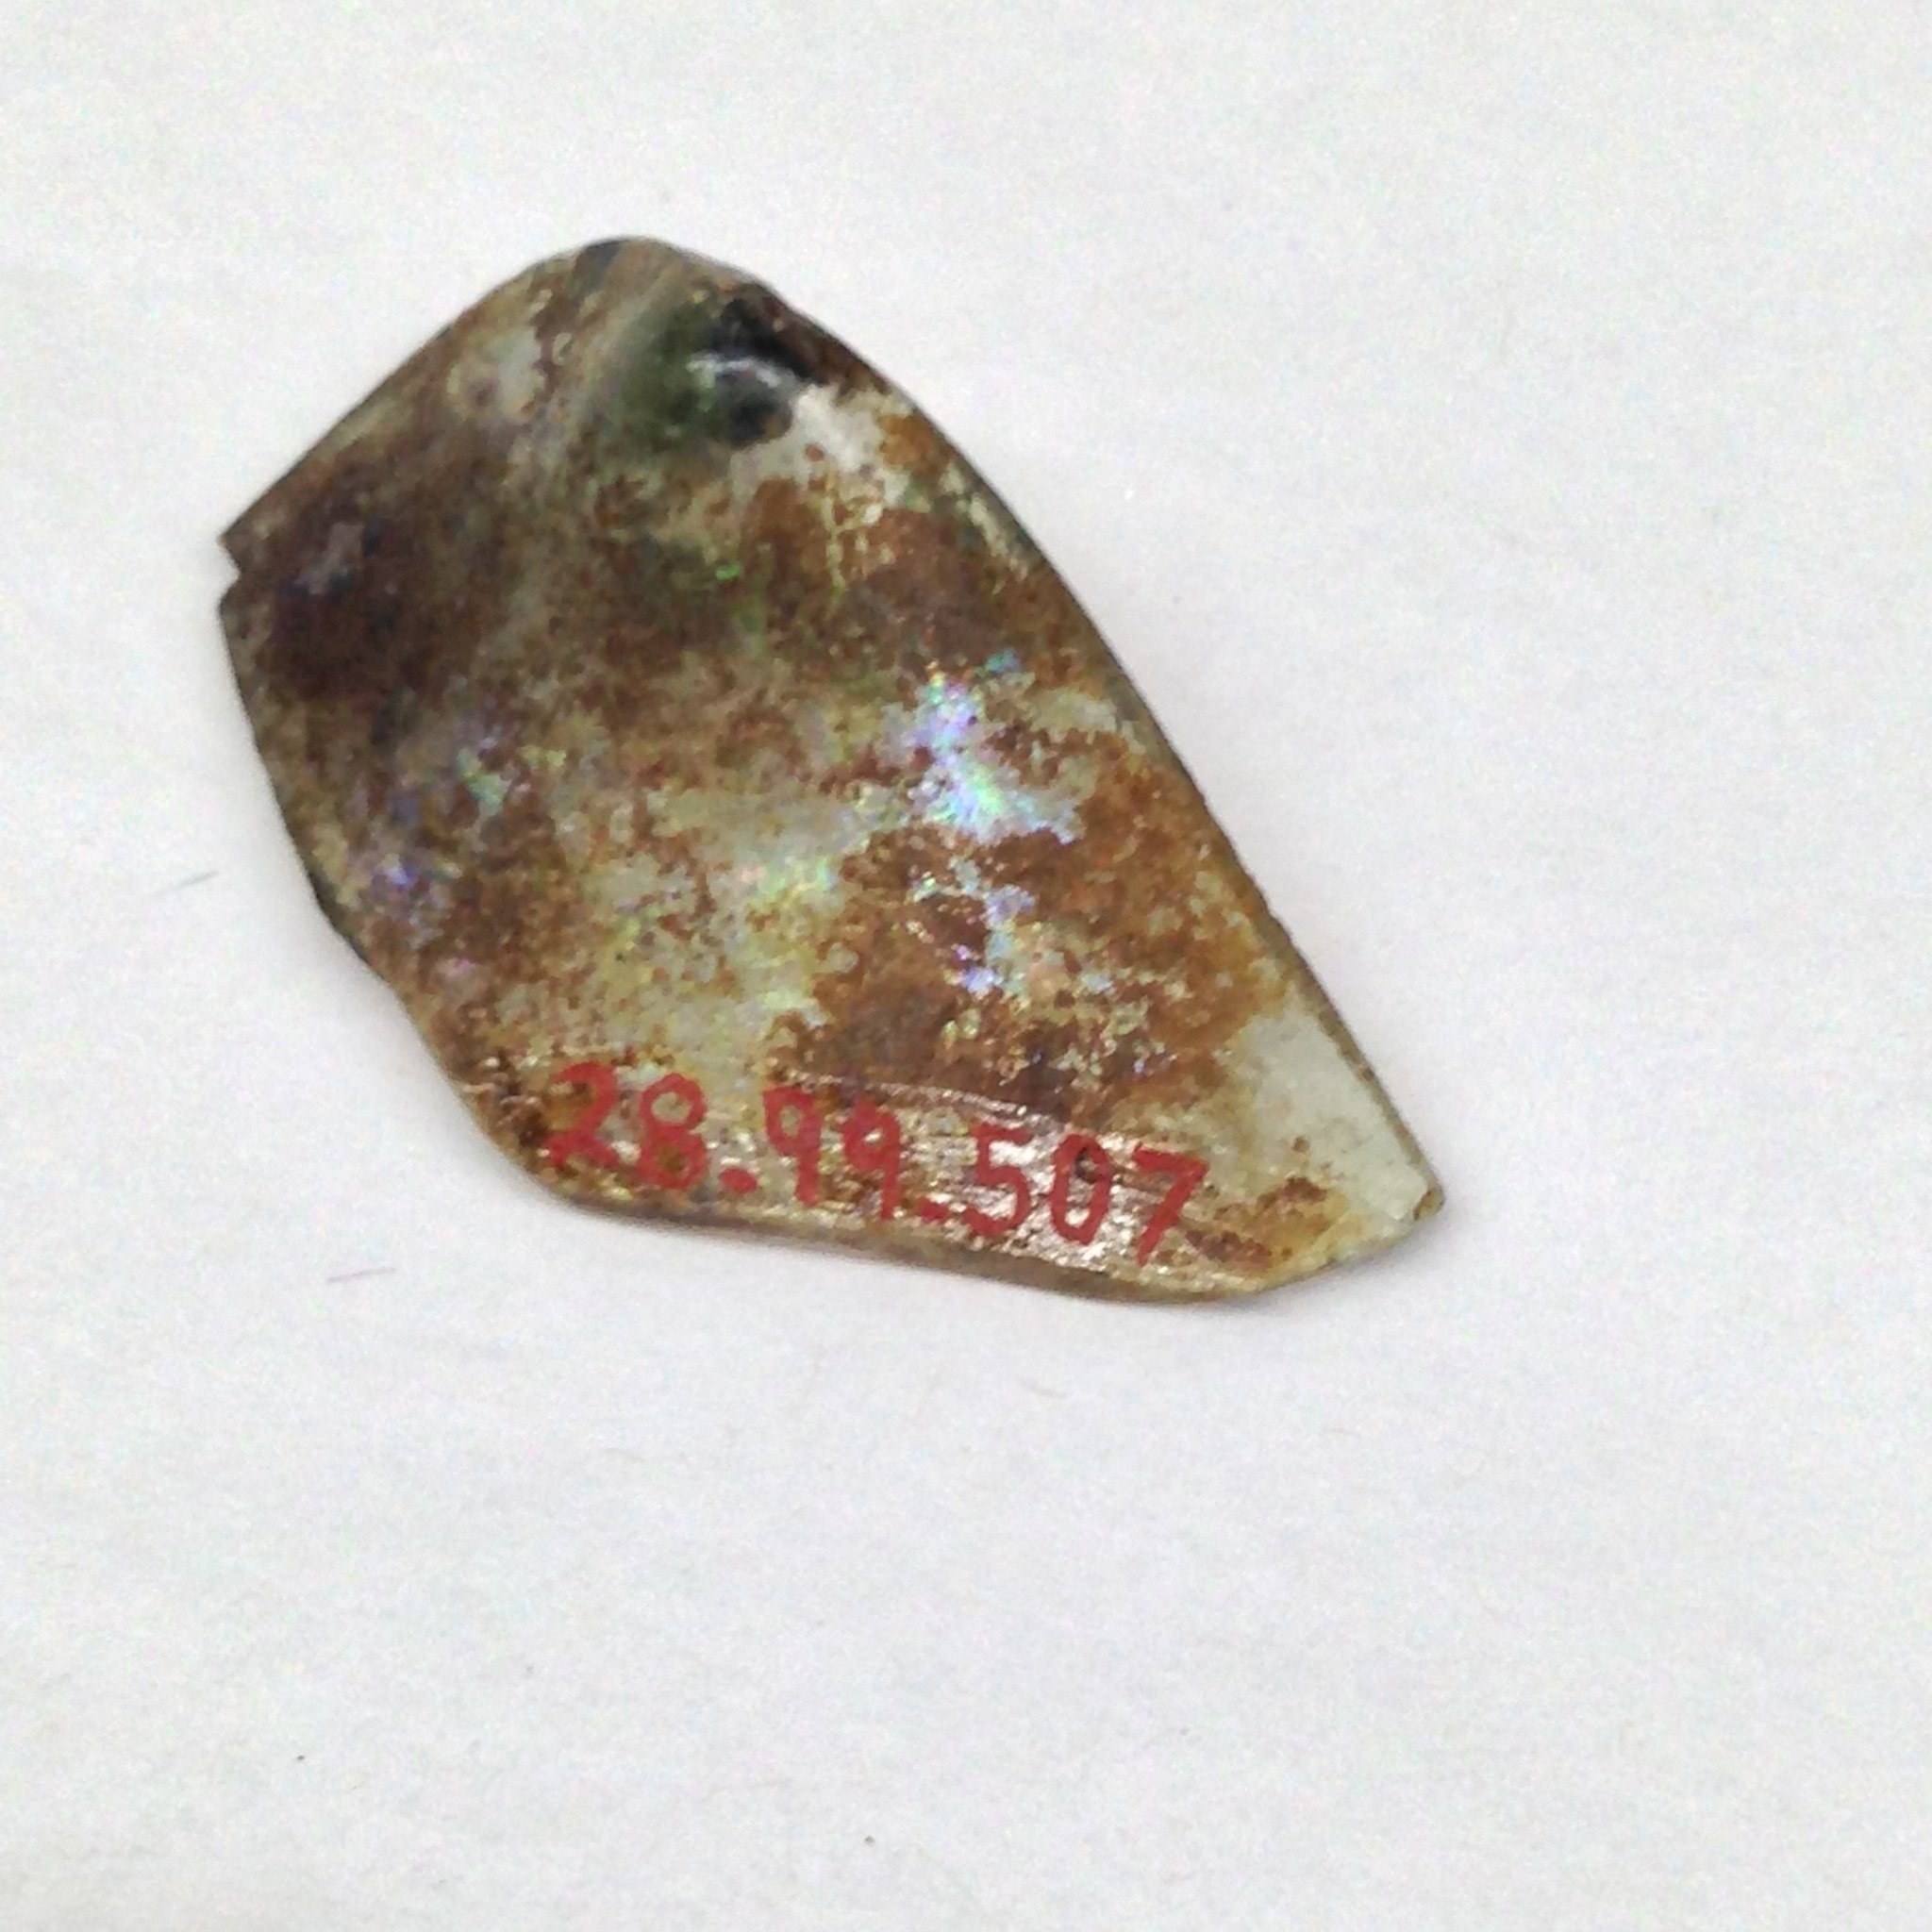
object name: fragment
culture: european or middle eastern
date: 1150-1250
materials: ceramic, glass